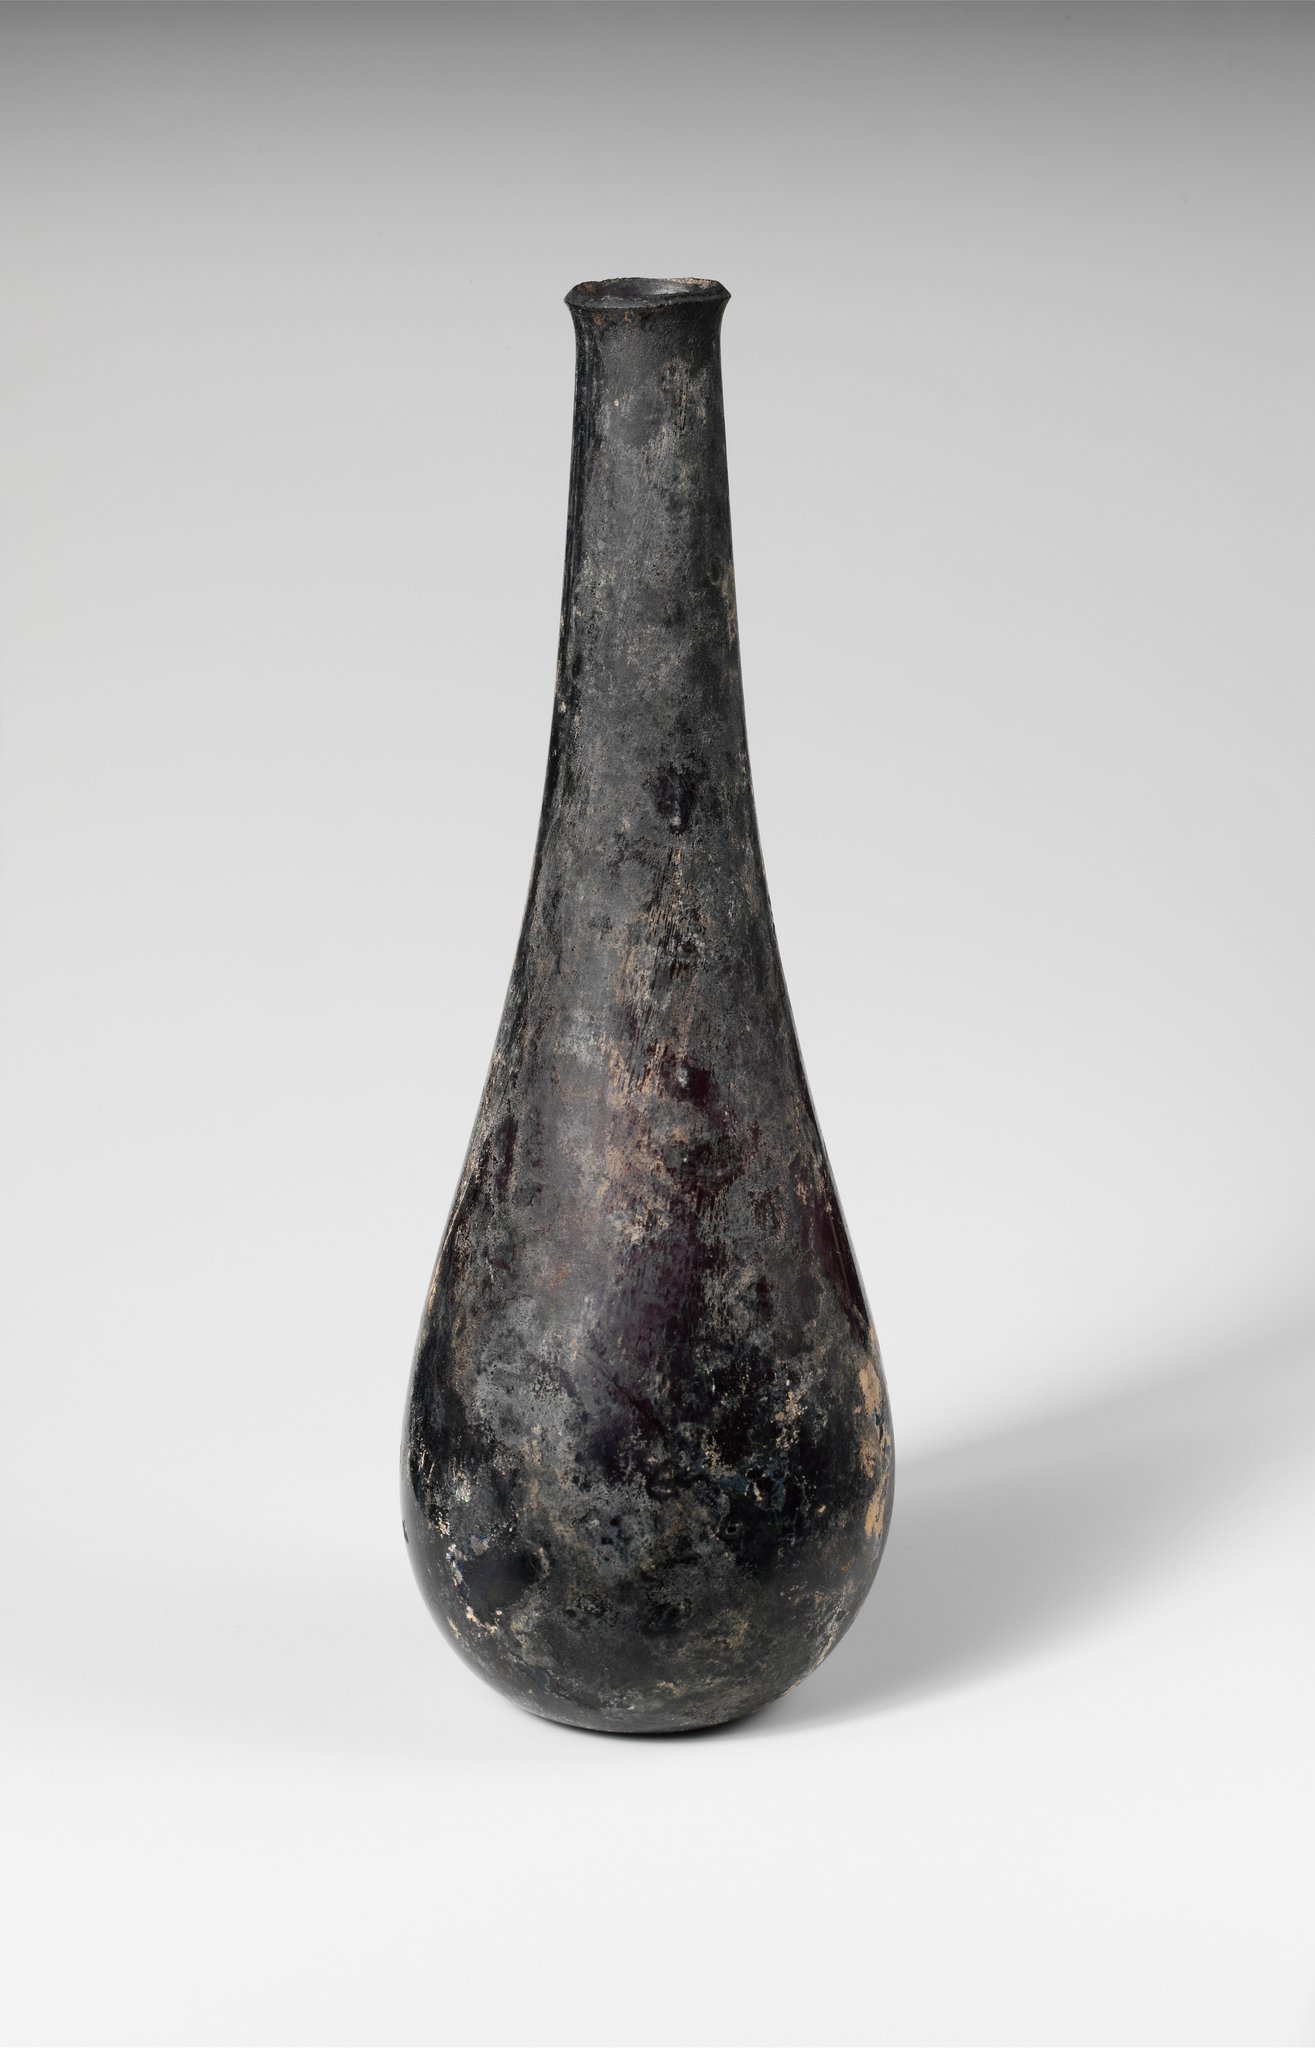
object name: bottle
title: Glass bottle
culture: roman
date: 301-500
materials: glass